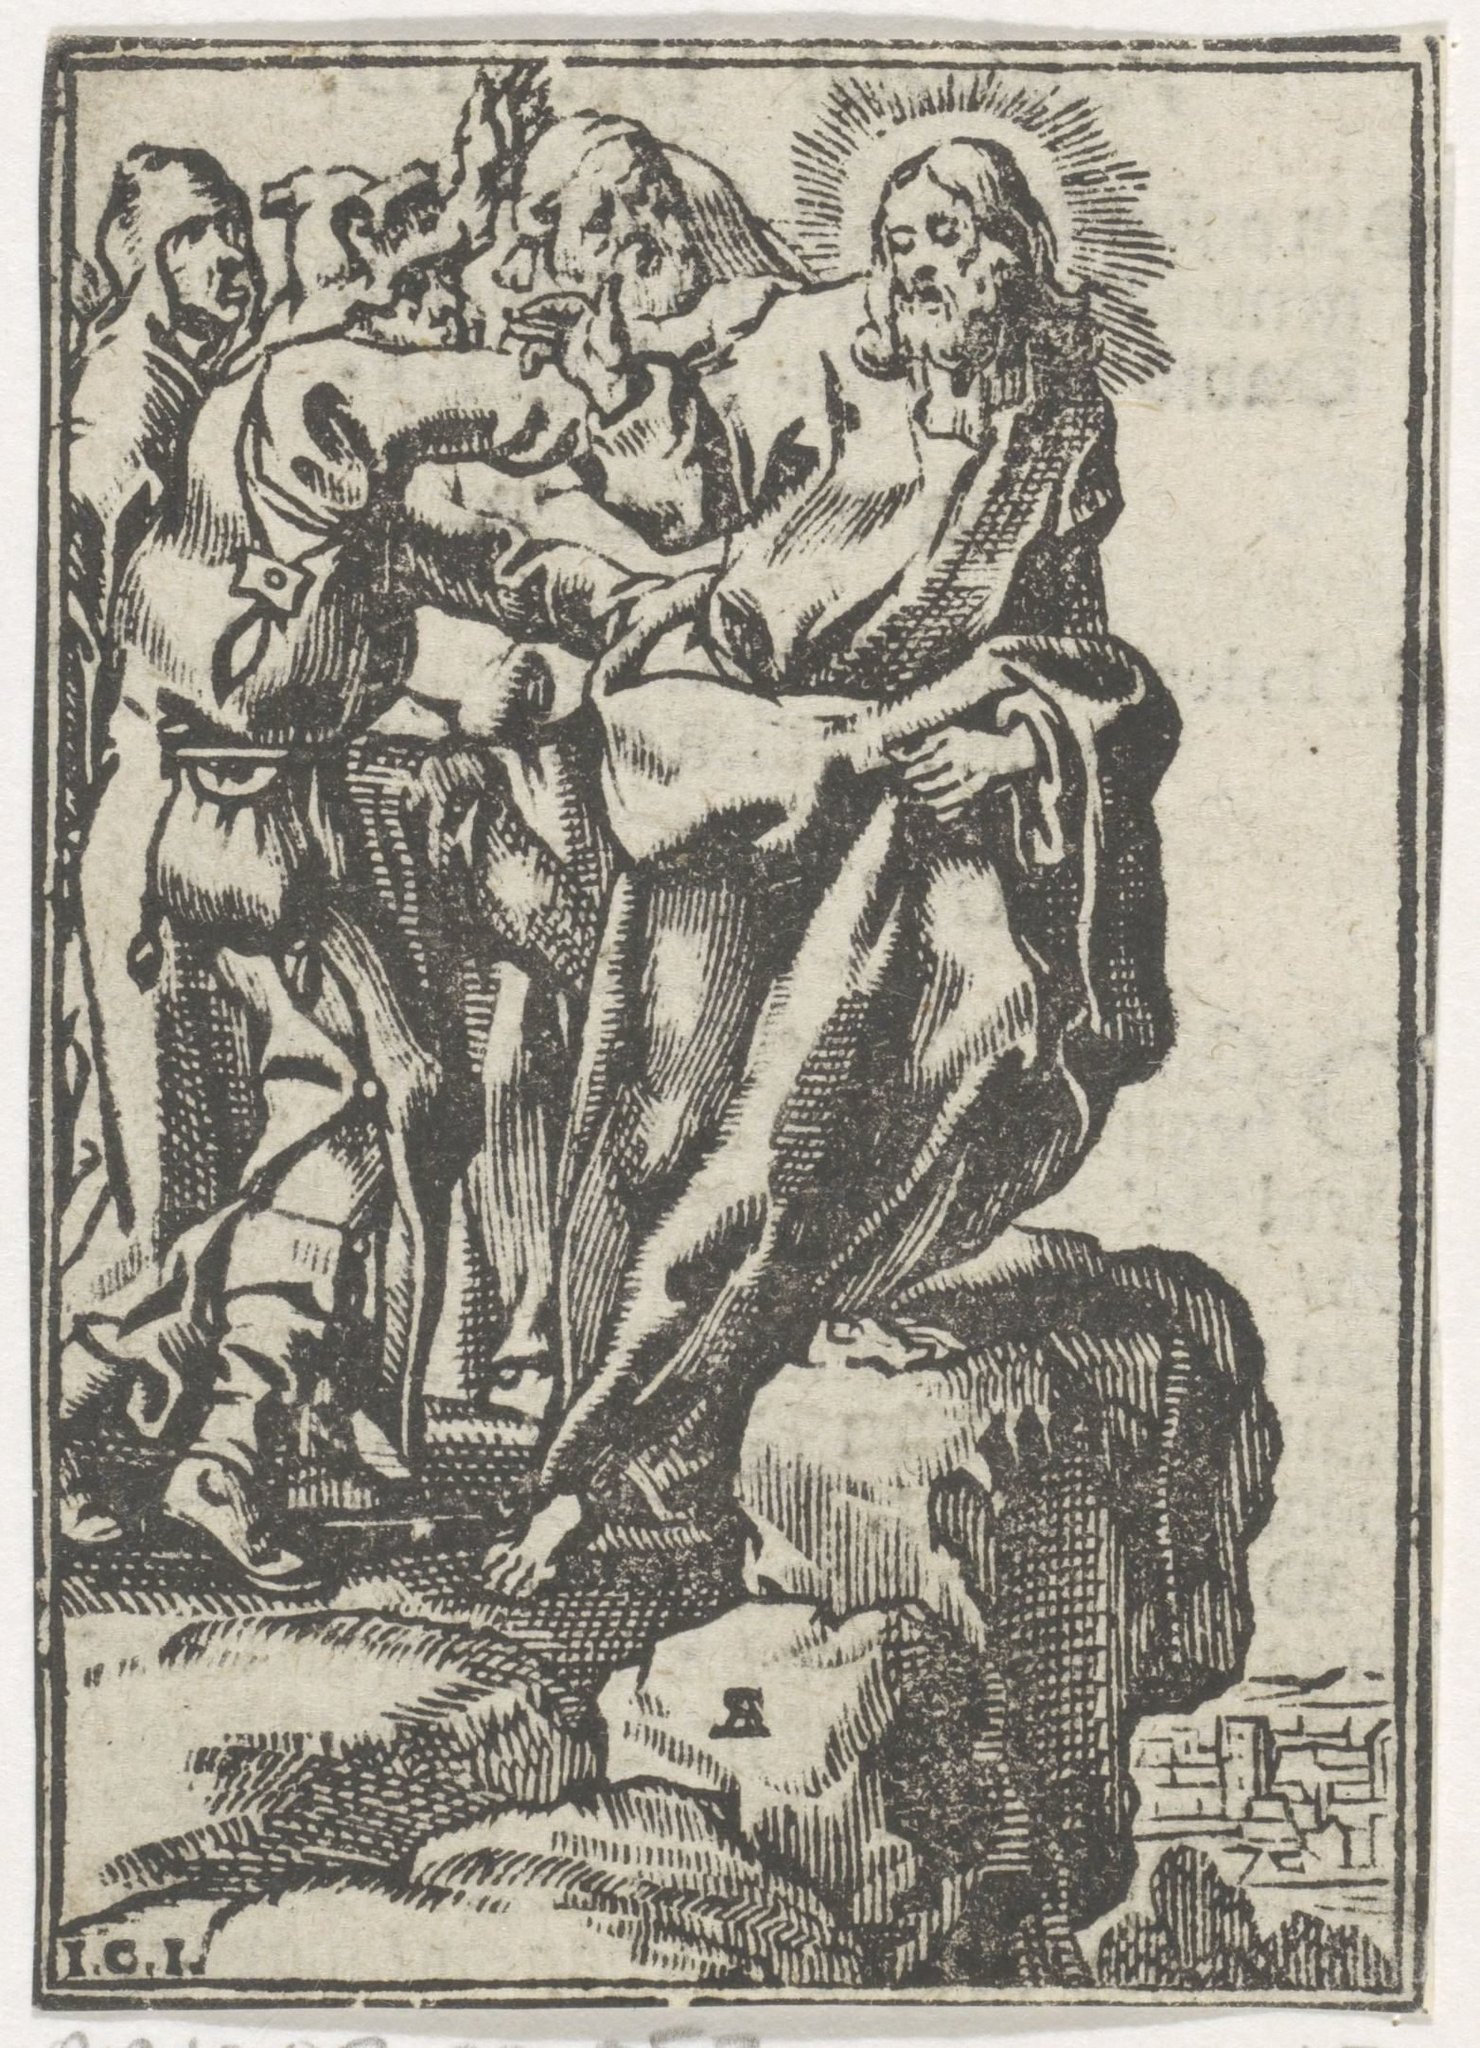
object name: print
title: Inwoners van Nazareth verdrijven Christus uit de stad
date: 1649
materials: paper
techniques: letterpress printing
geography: antwerp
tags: rejection of christ's preaching in nazareth: 'a prophet is not without honour except in his own country ...' (matthew 13:54-57; mark 6:1-4; luke 4:22-24; john 4:44)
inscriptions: collector's mark: Lugt 2228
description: De inwoners van Nazareth verdrijven Christus de stad uit, naar de rand van de berg waarop hun stad gebouwd was, om hem in de afgrond te storten.